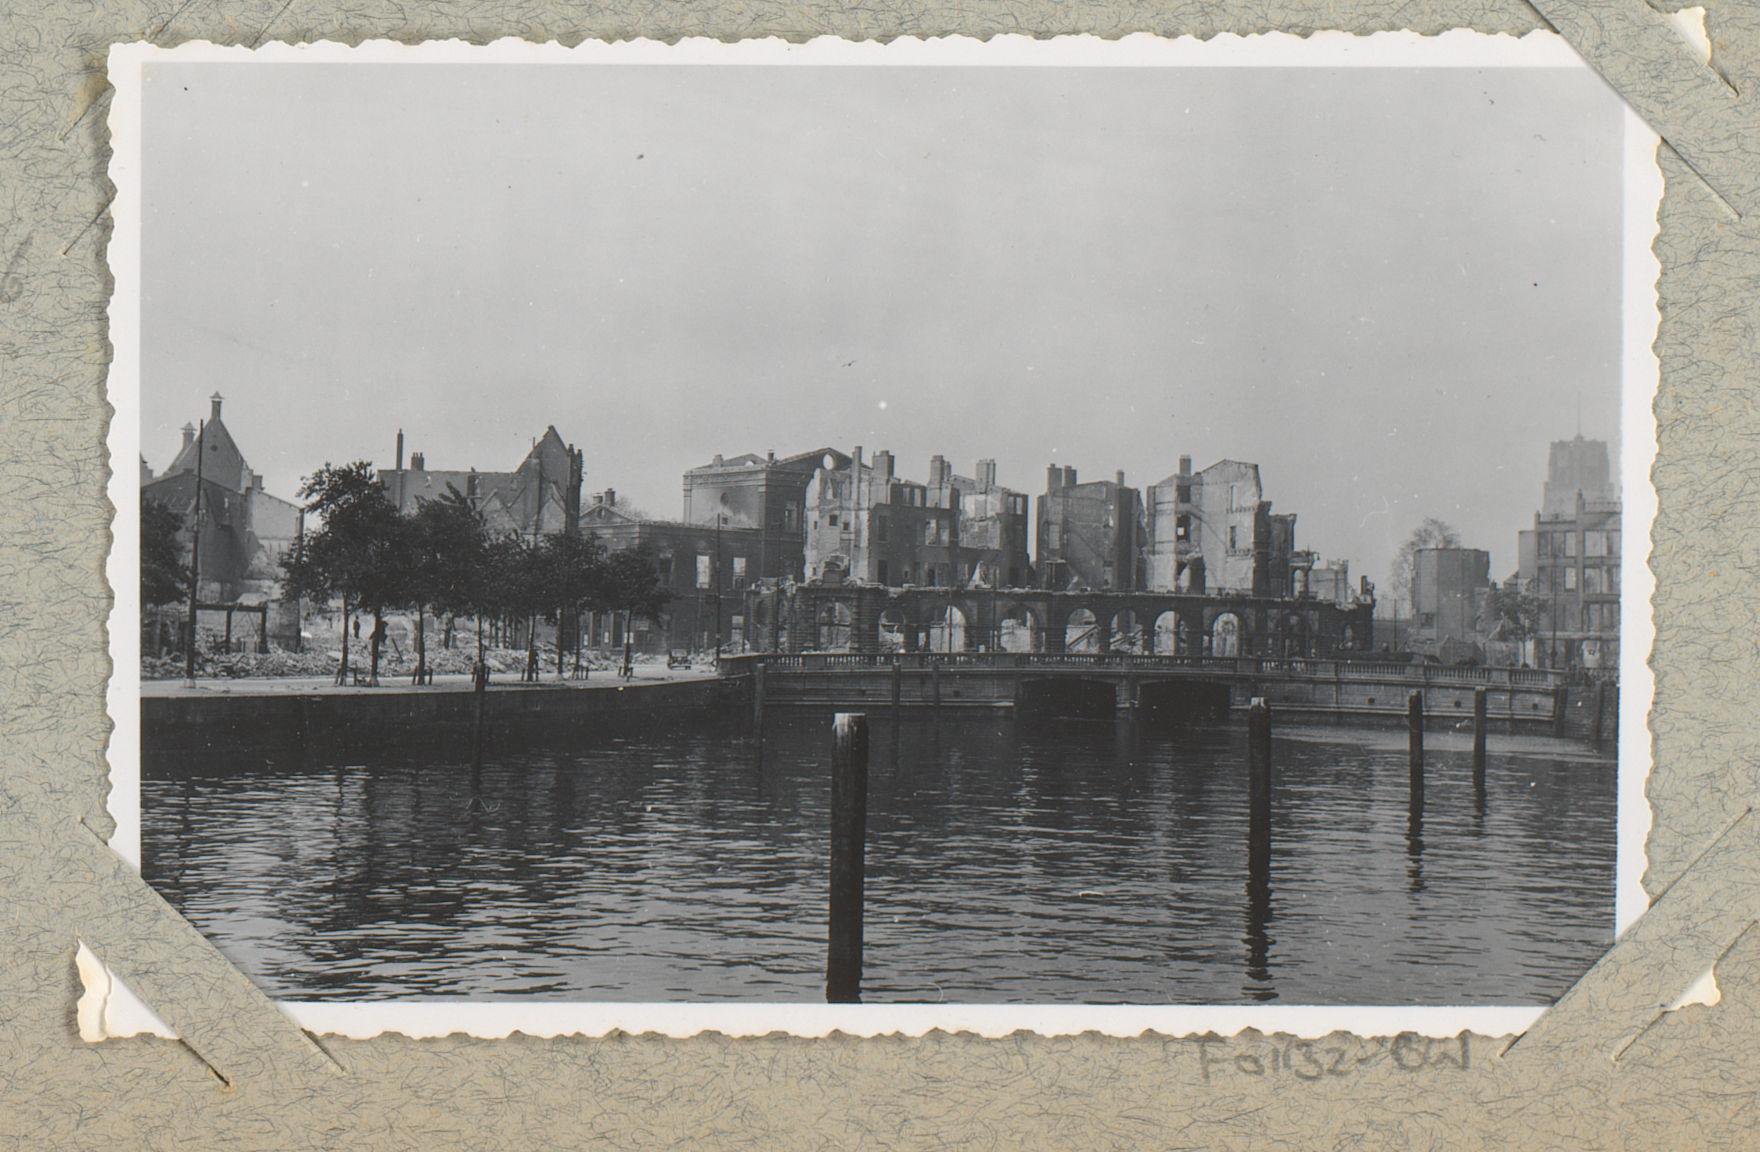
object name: photograph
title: Ruïnes van Plan C, gezien vanaf het water, te Rotterdam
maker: j. nolte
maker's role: fotograaf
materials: photographic support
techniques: gelatin silver print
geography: rotterdam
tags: devastated, ruined place or city (~ warfare), ruin of a dwelling, house, castle, etc., rotterdam, rotterdam blitz